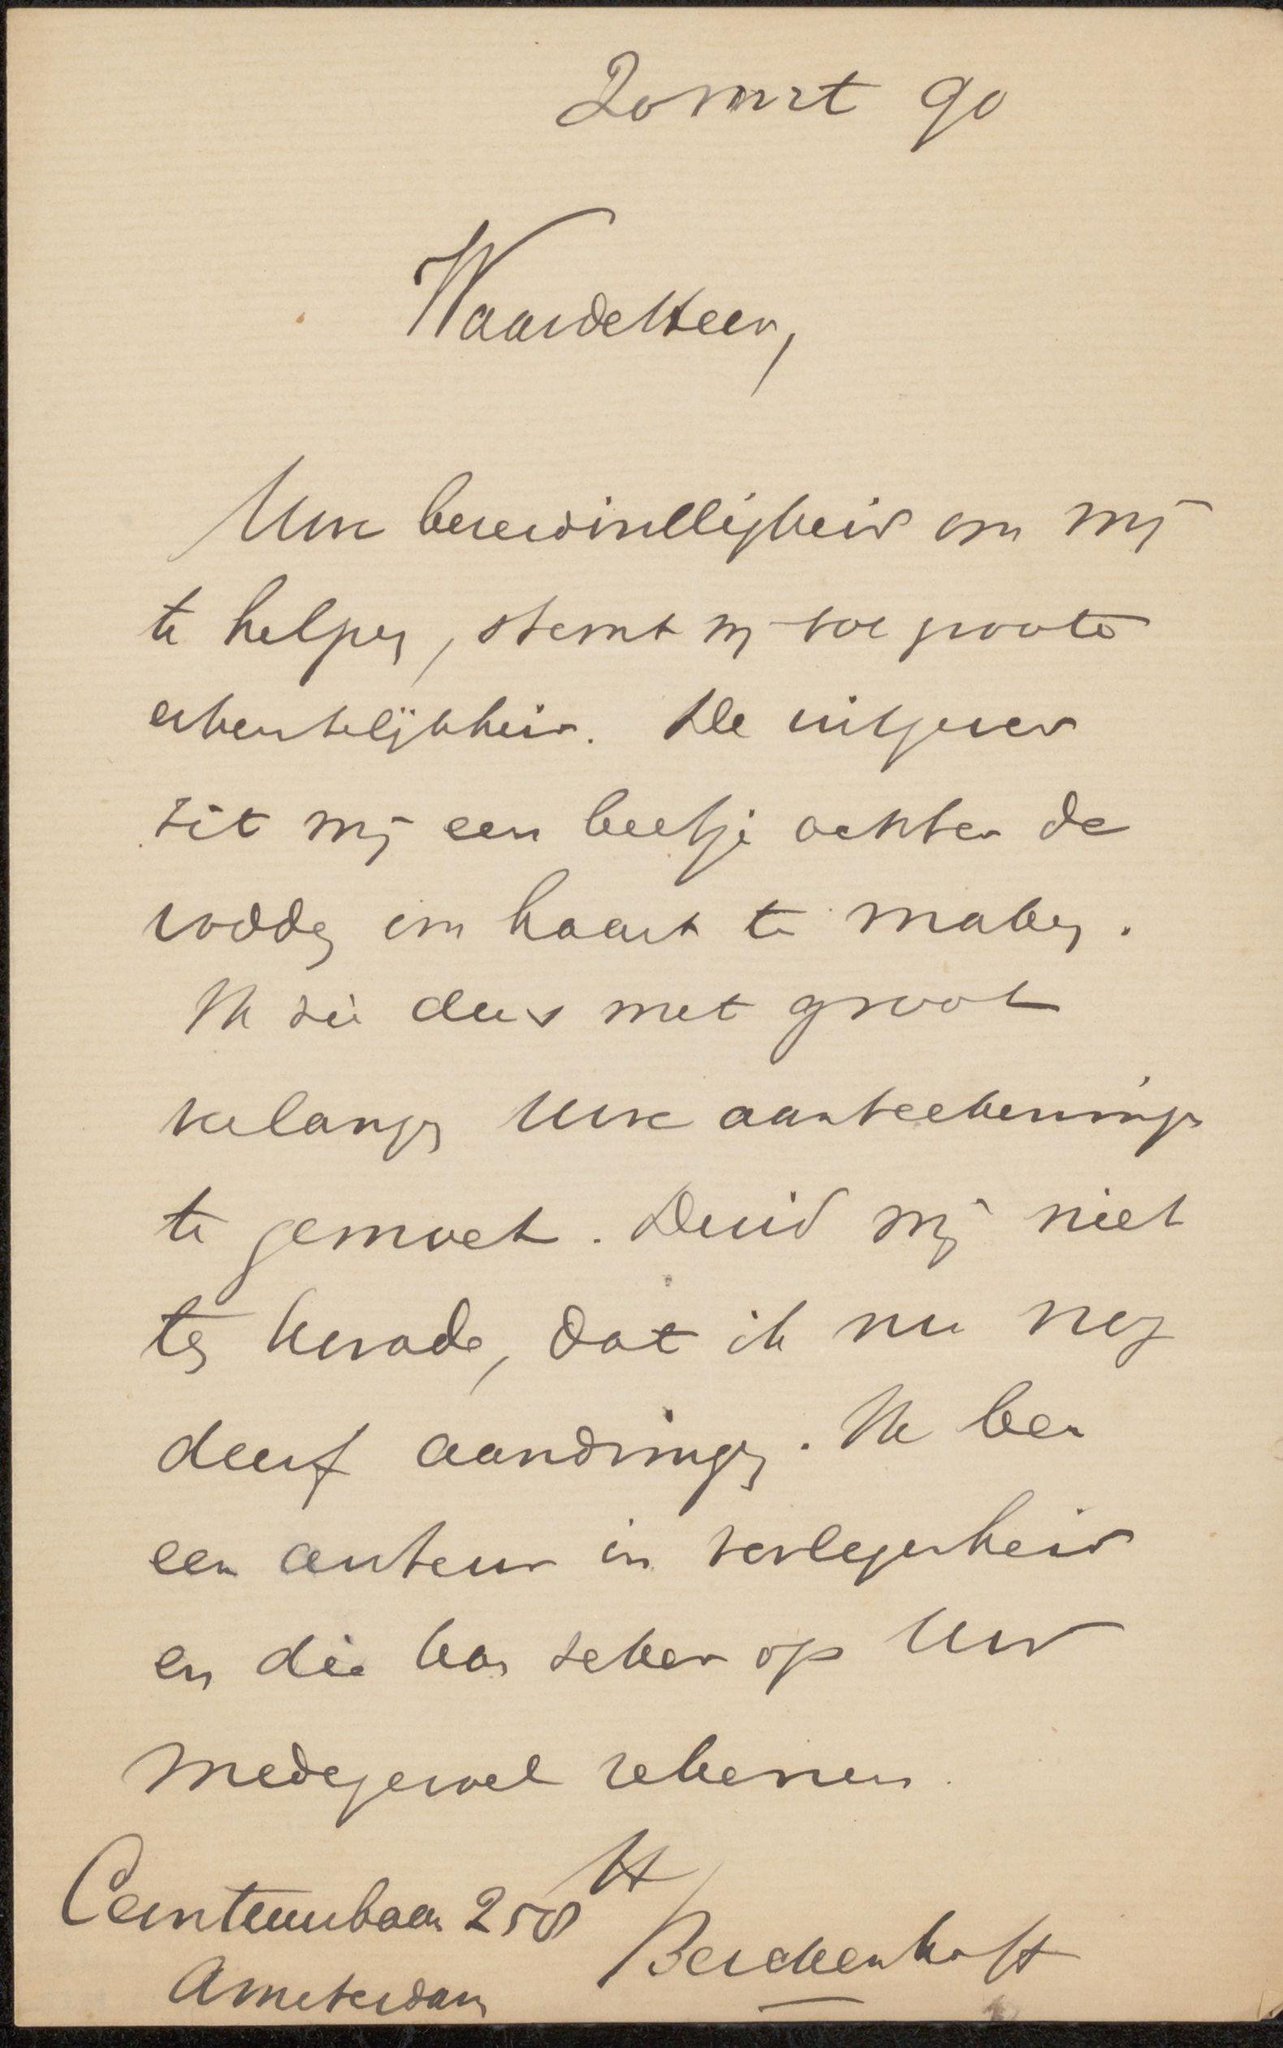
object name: letter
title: Brief aan Philip Zilcken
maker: h.l. berckenhoff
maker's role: redacteur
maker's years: 1850-1918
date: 1890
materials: ink, paper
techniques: pen, writing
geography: amsterdam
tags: the hague, painter, philip zilcken, literature ~ arts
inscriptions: collector's mark: ‘RPK’